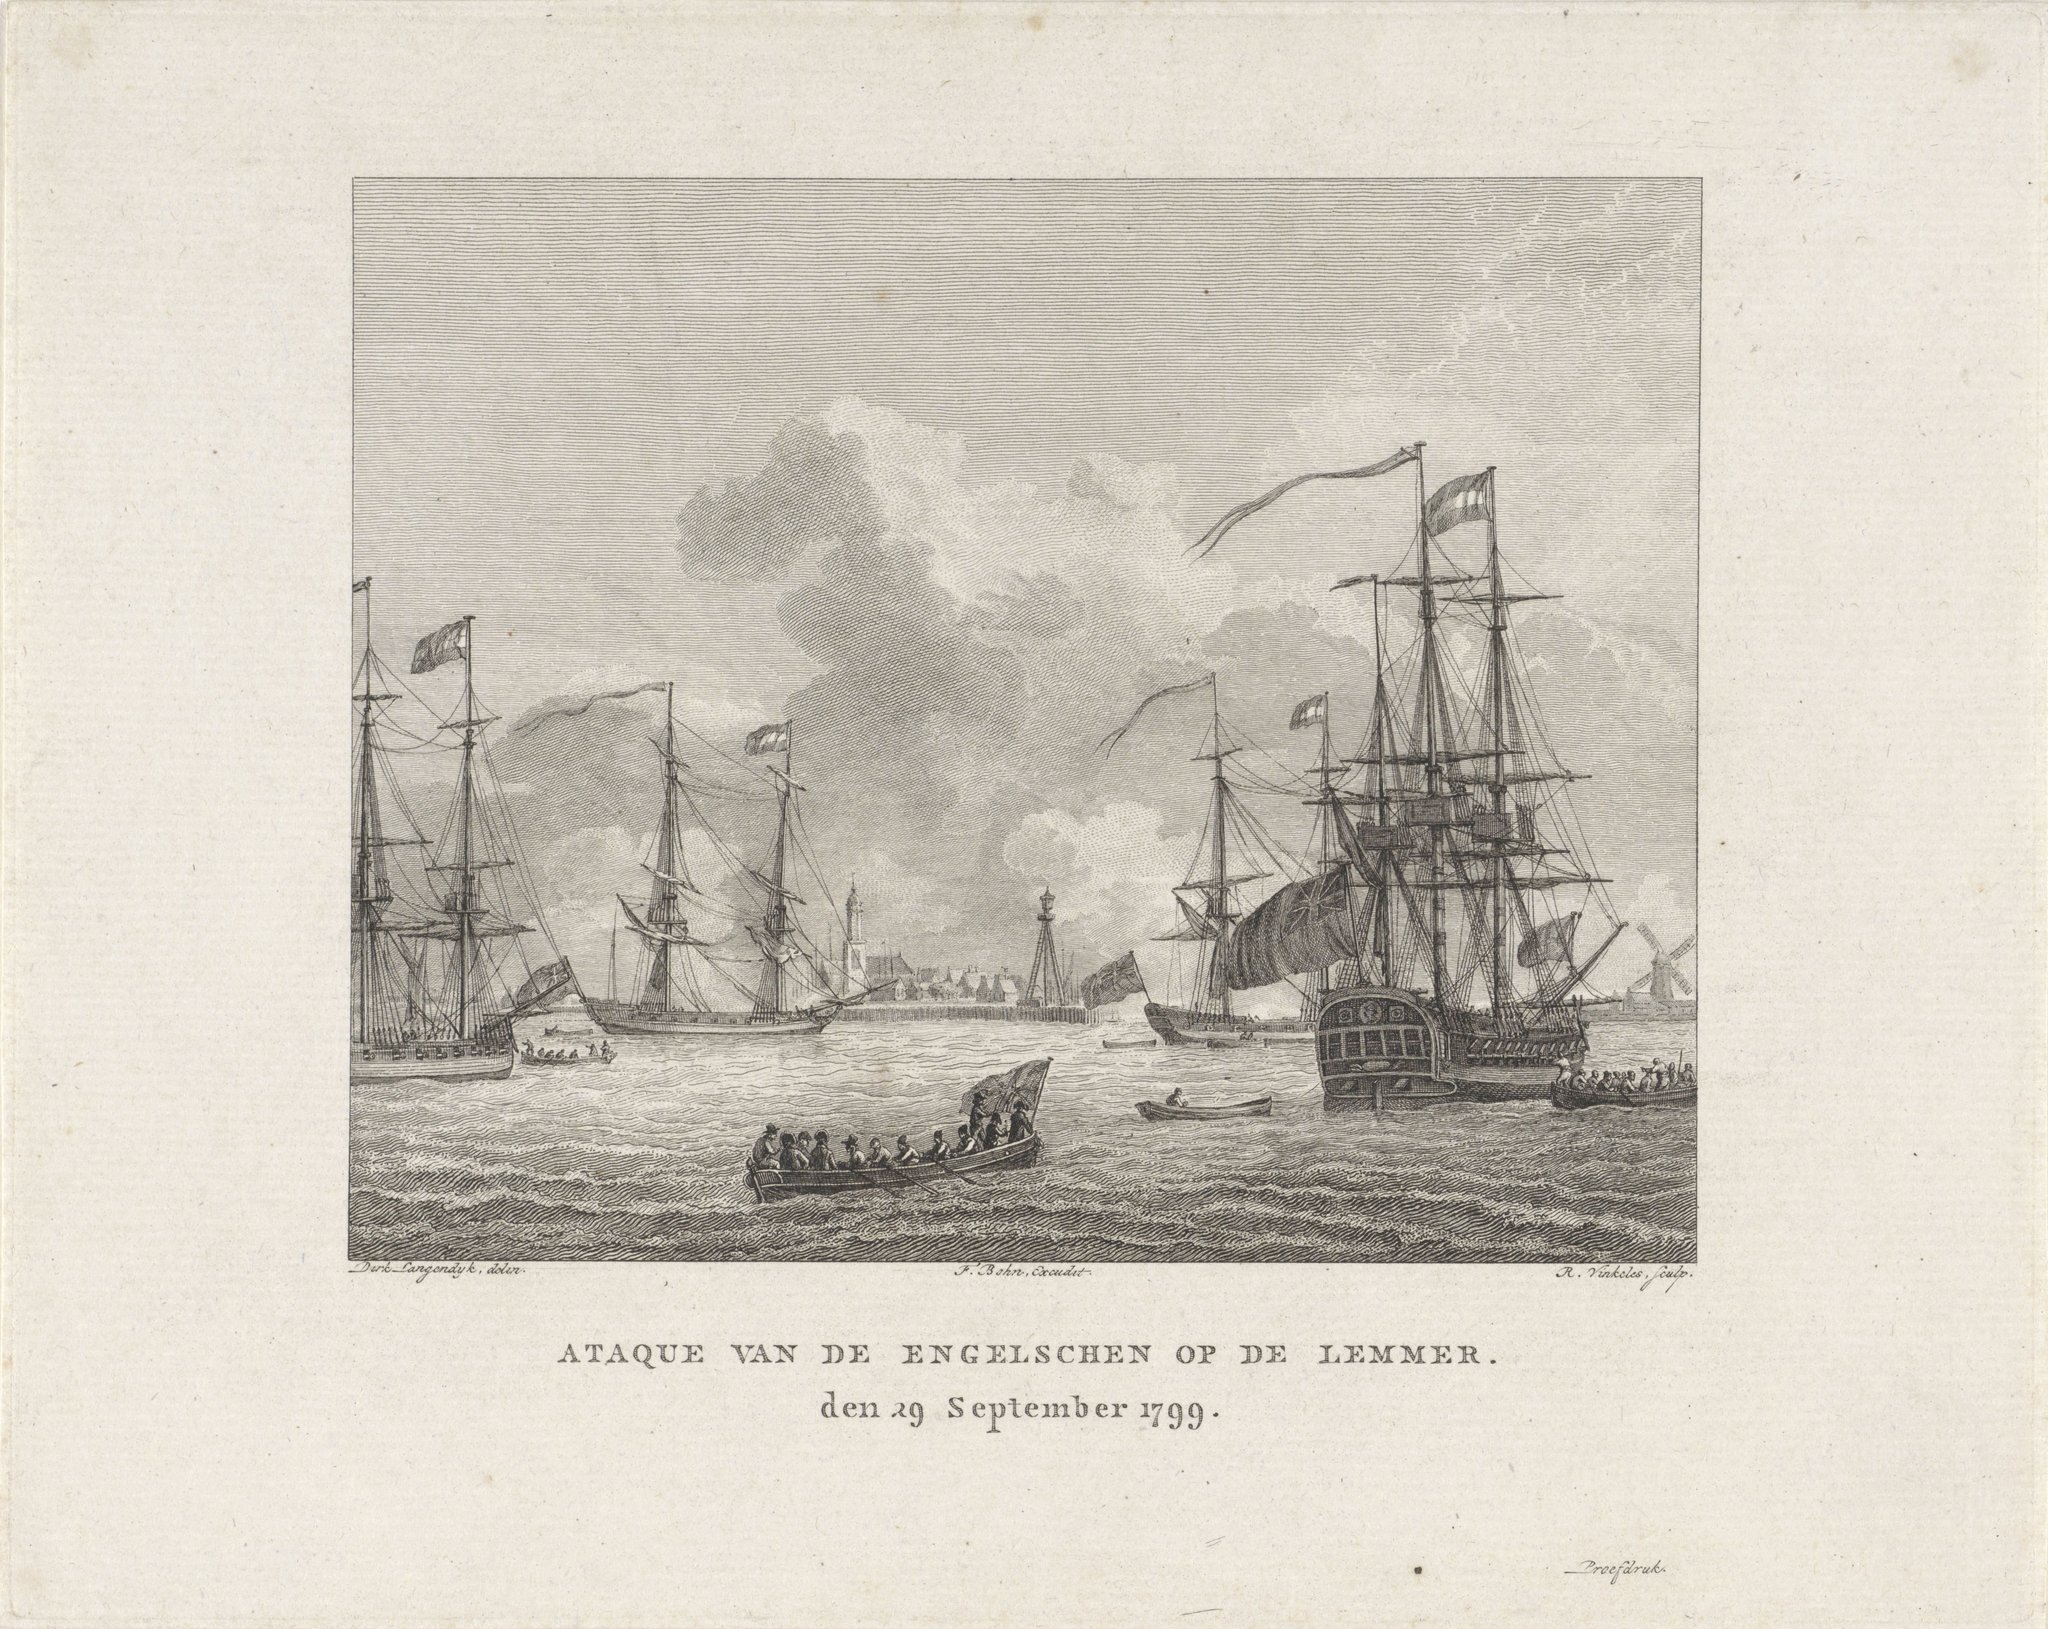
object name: print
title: Aanval van de Britten op Lemmer, 1799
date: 1800-1802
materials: paper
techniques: engraving, etching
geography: den helder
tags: windmill, battle (+ sailing-ships)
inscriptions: collector's mark: Lugt 240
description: Gebruikt als illustratie in: L.C. Vonk. Geschiedenis der landing van het Engelsch-Russisch leger in Noord-Holland; alsmede der krijgsbedrijven en politieke gebeurtenissen, zoo aldaar, als in Vriesland en Gelderland, in den jare 1799. Haarlem: François Bohn, 2 dln, 1801-1802.